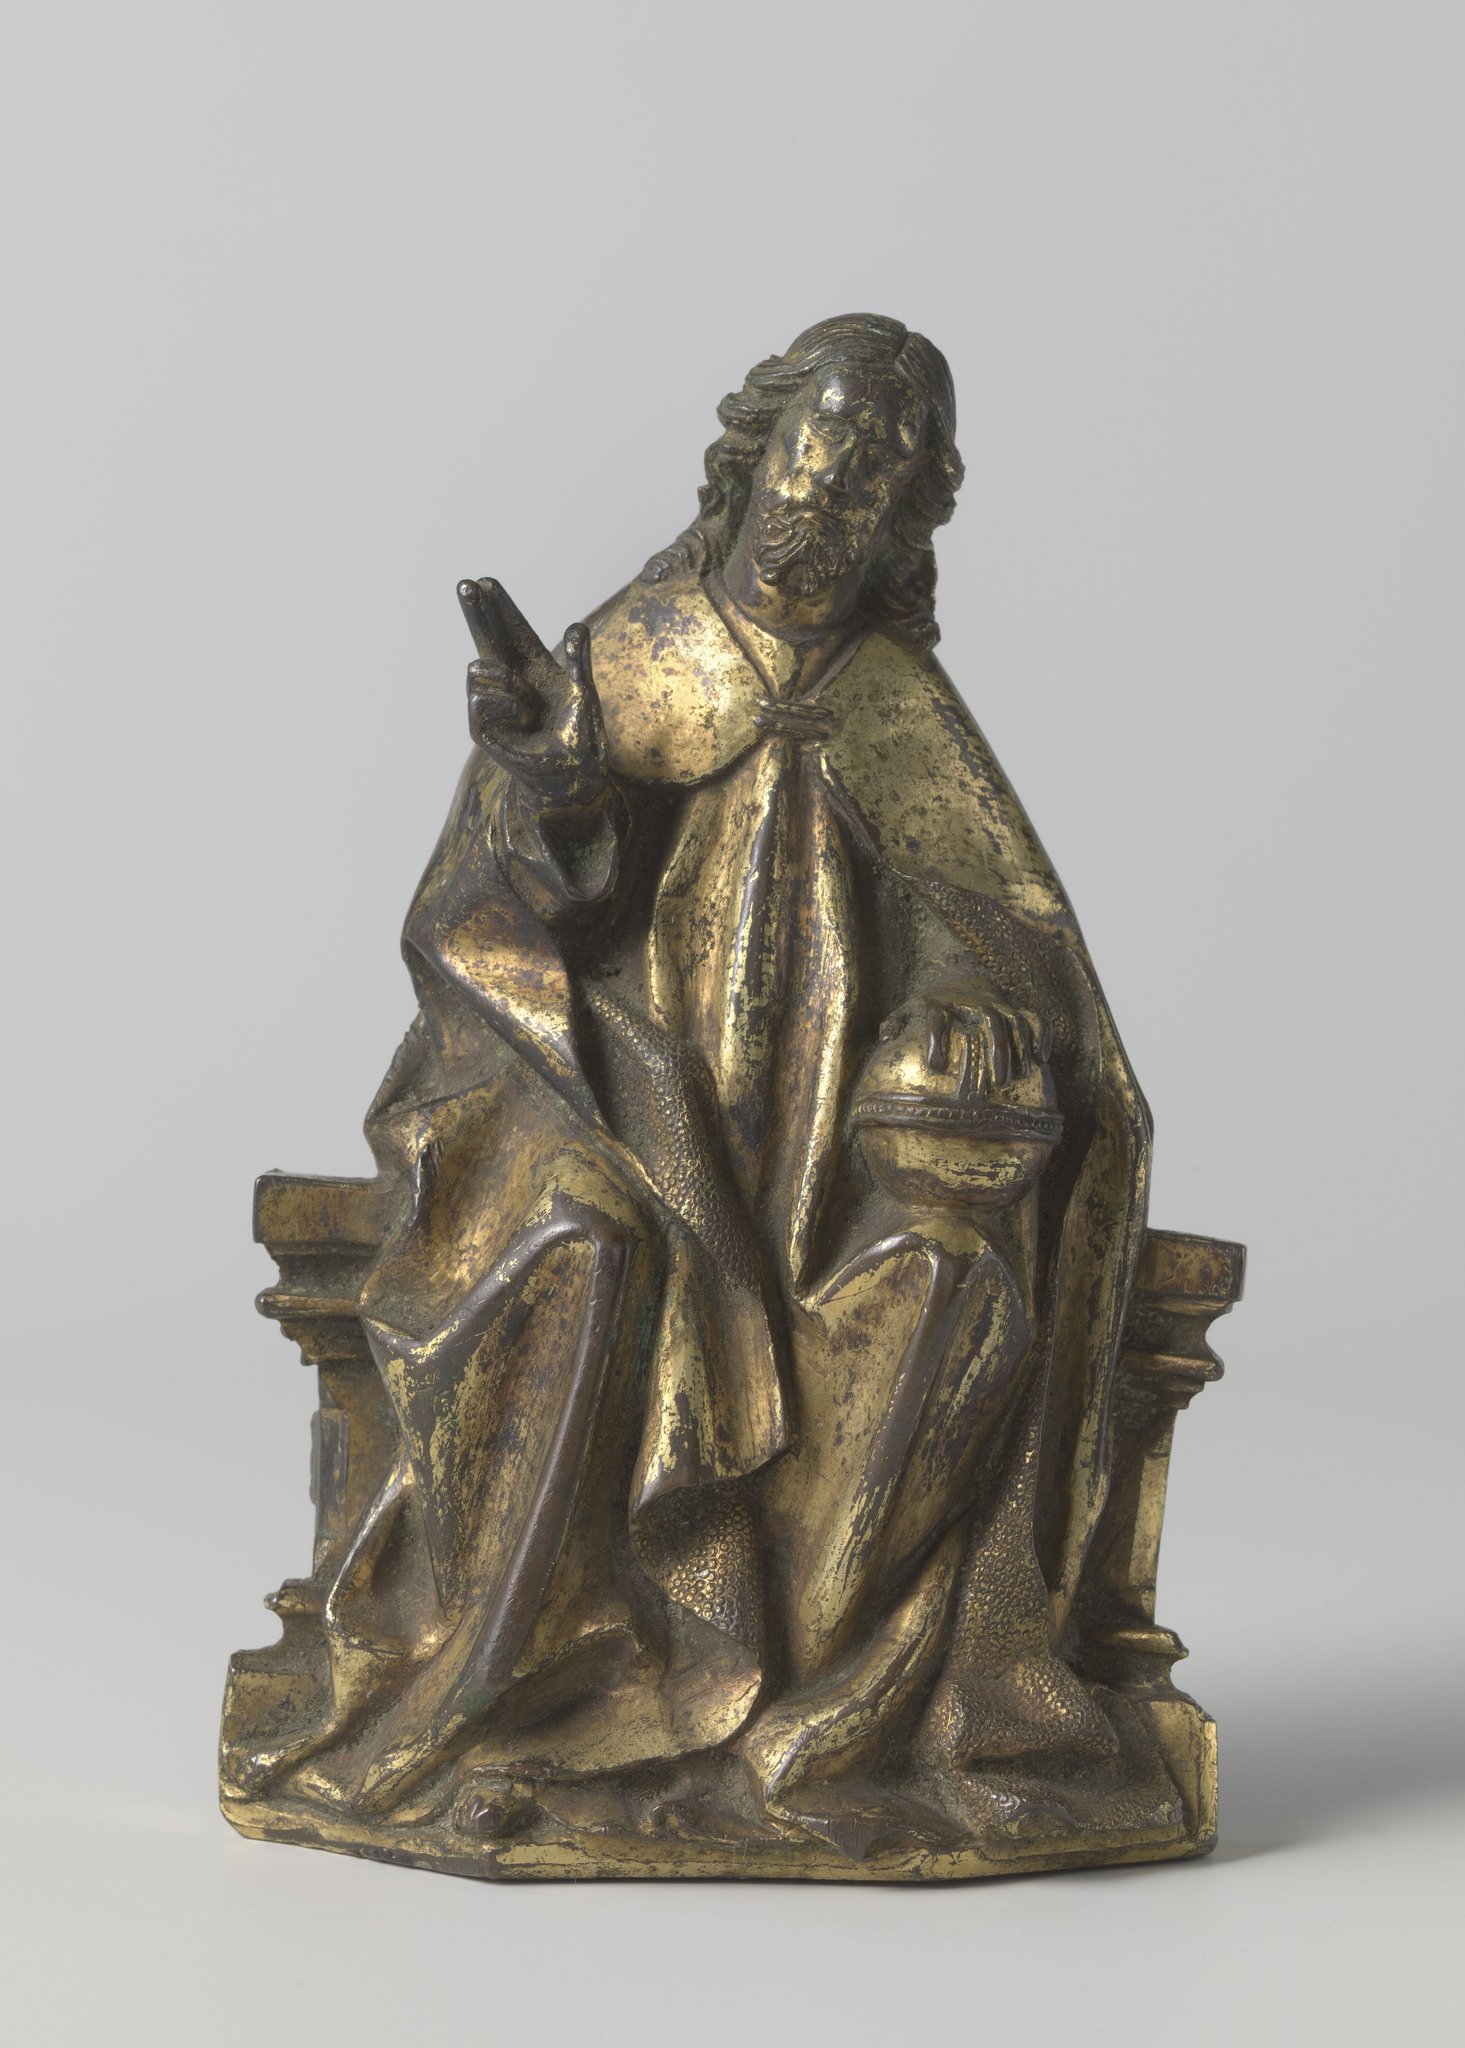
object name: figure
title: Christ as Salvator Mundi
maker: master arnt of kalkar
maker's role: sculptor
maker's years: -1492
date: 1480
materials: bronze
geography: kalkar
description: Arnt van Kalkar (?). Christ Blessing. Gilt bronze. Lower Rhine, c. 1480 - 1490.